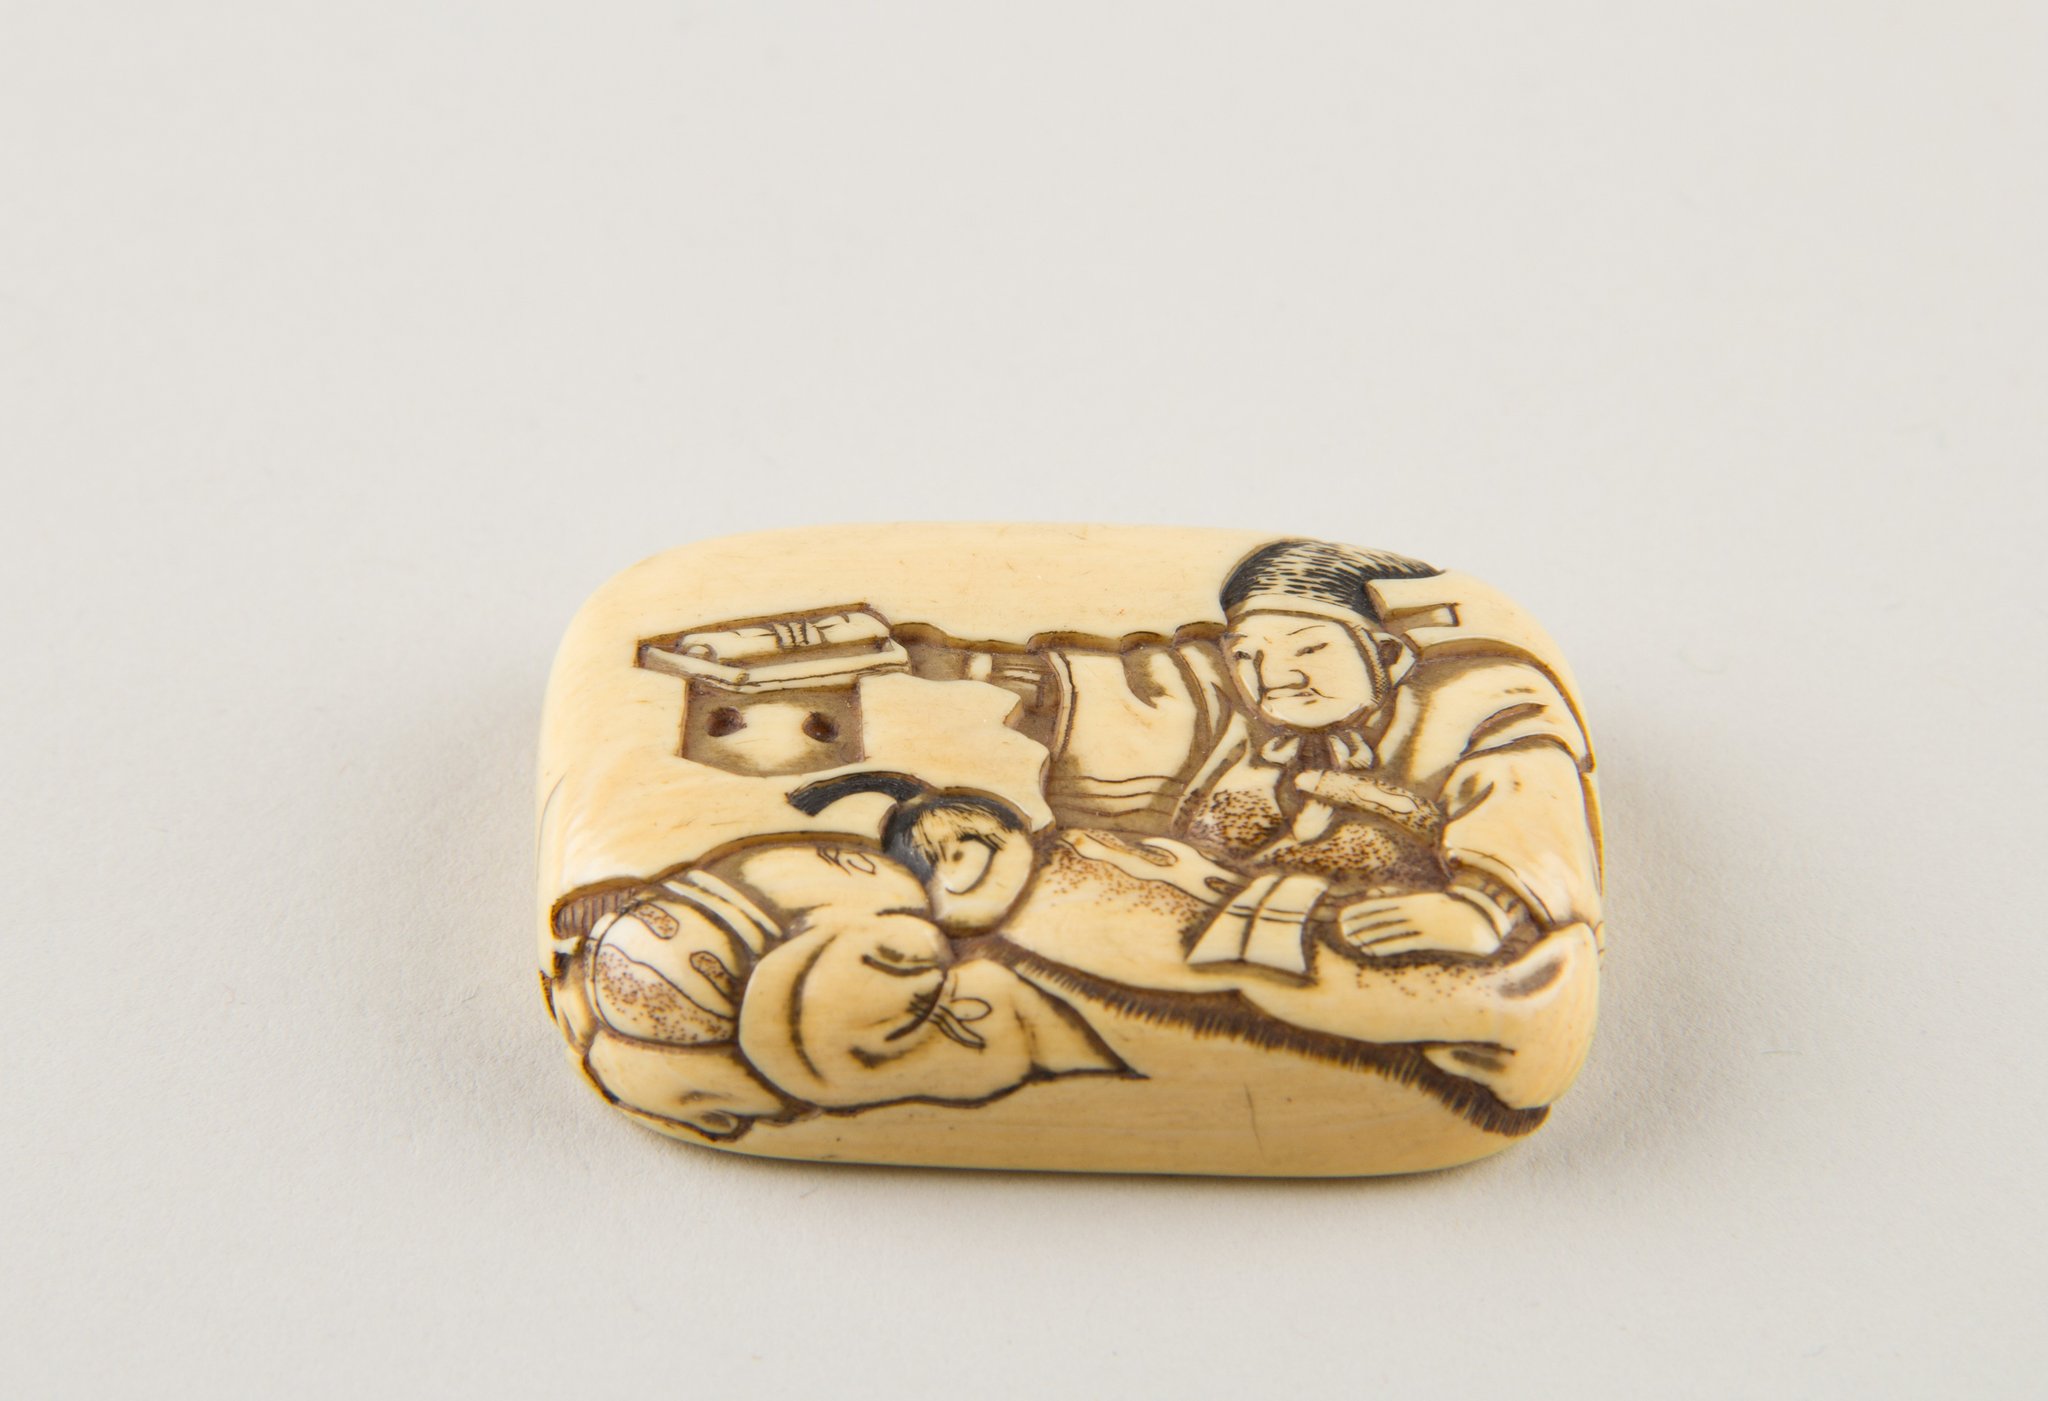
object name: netsuke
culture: japanese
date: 1801-1900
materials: ivory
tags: human figures